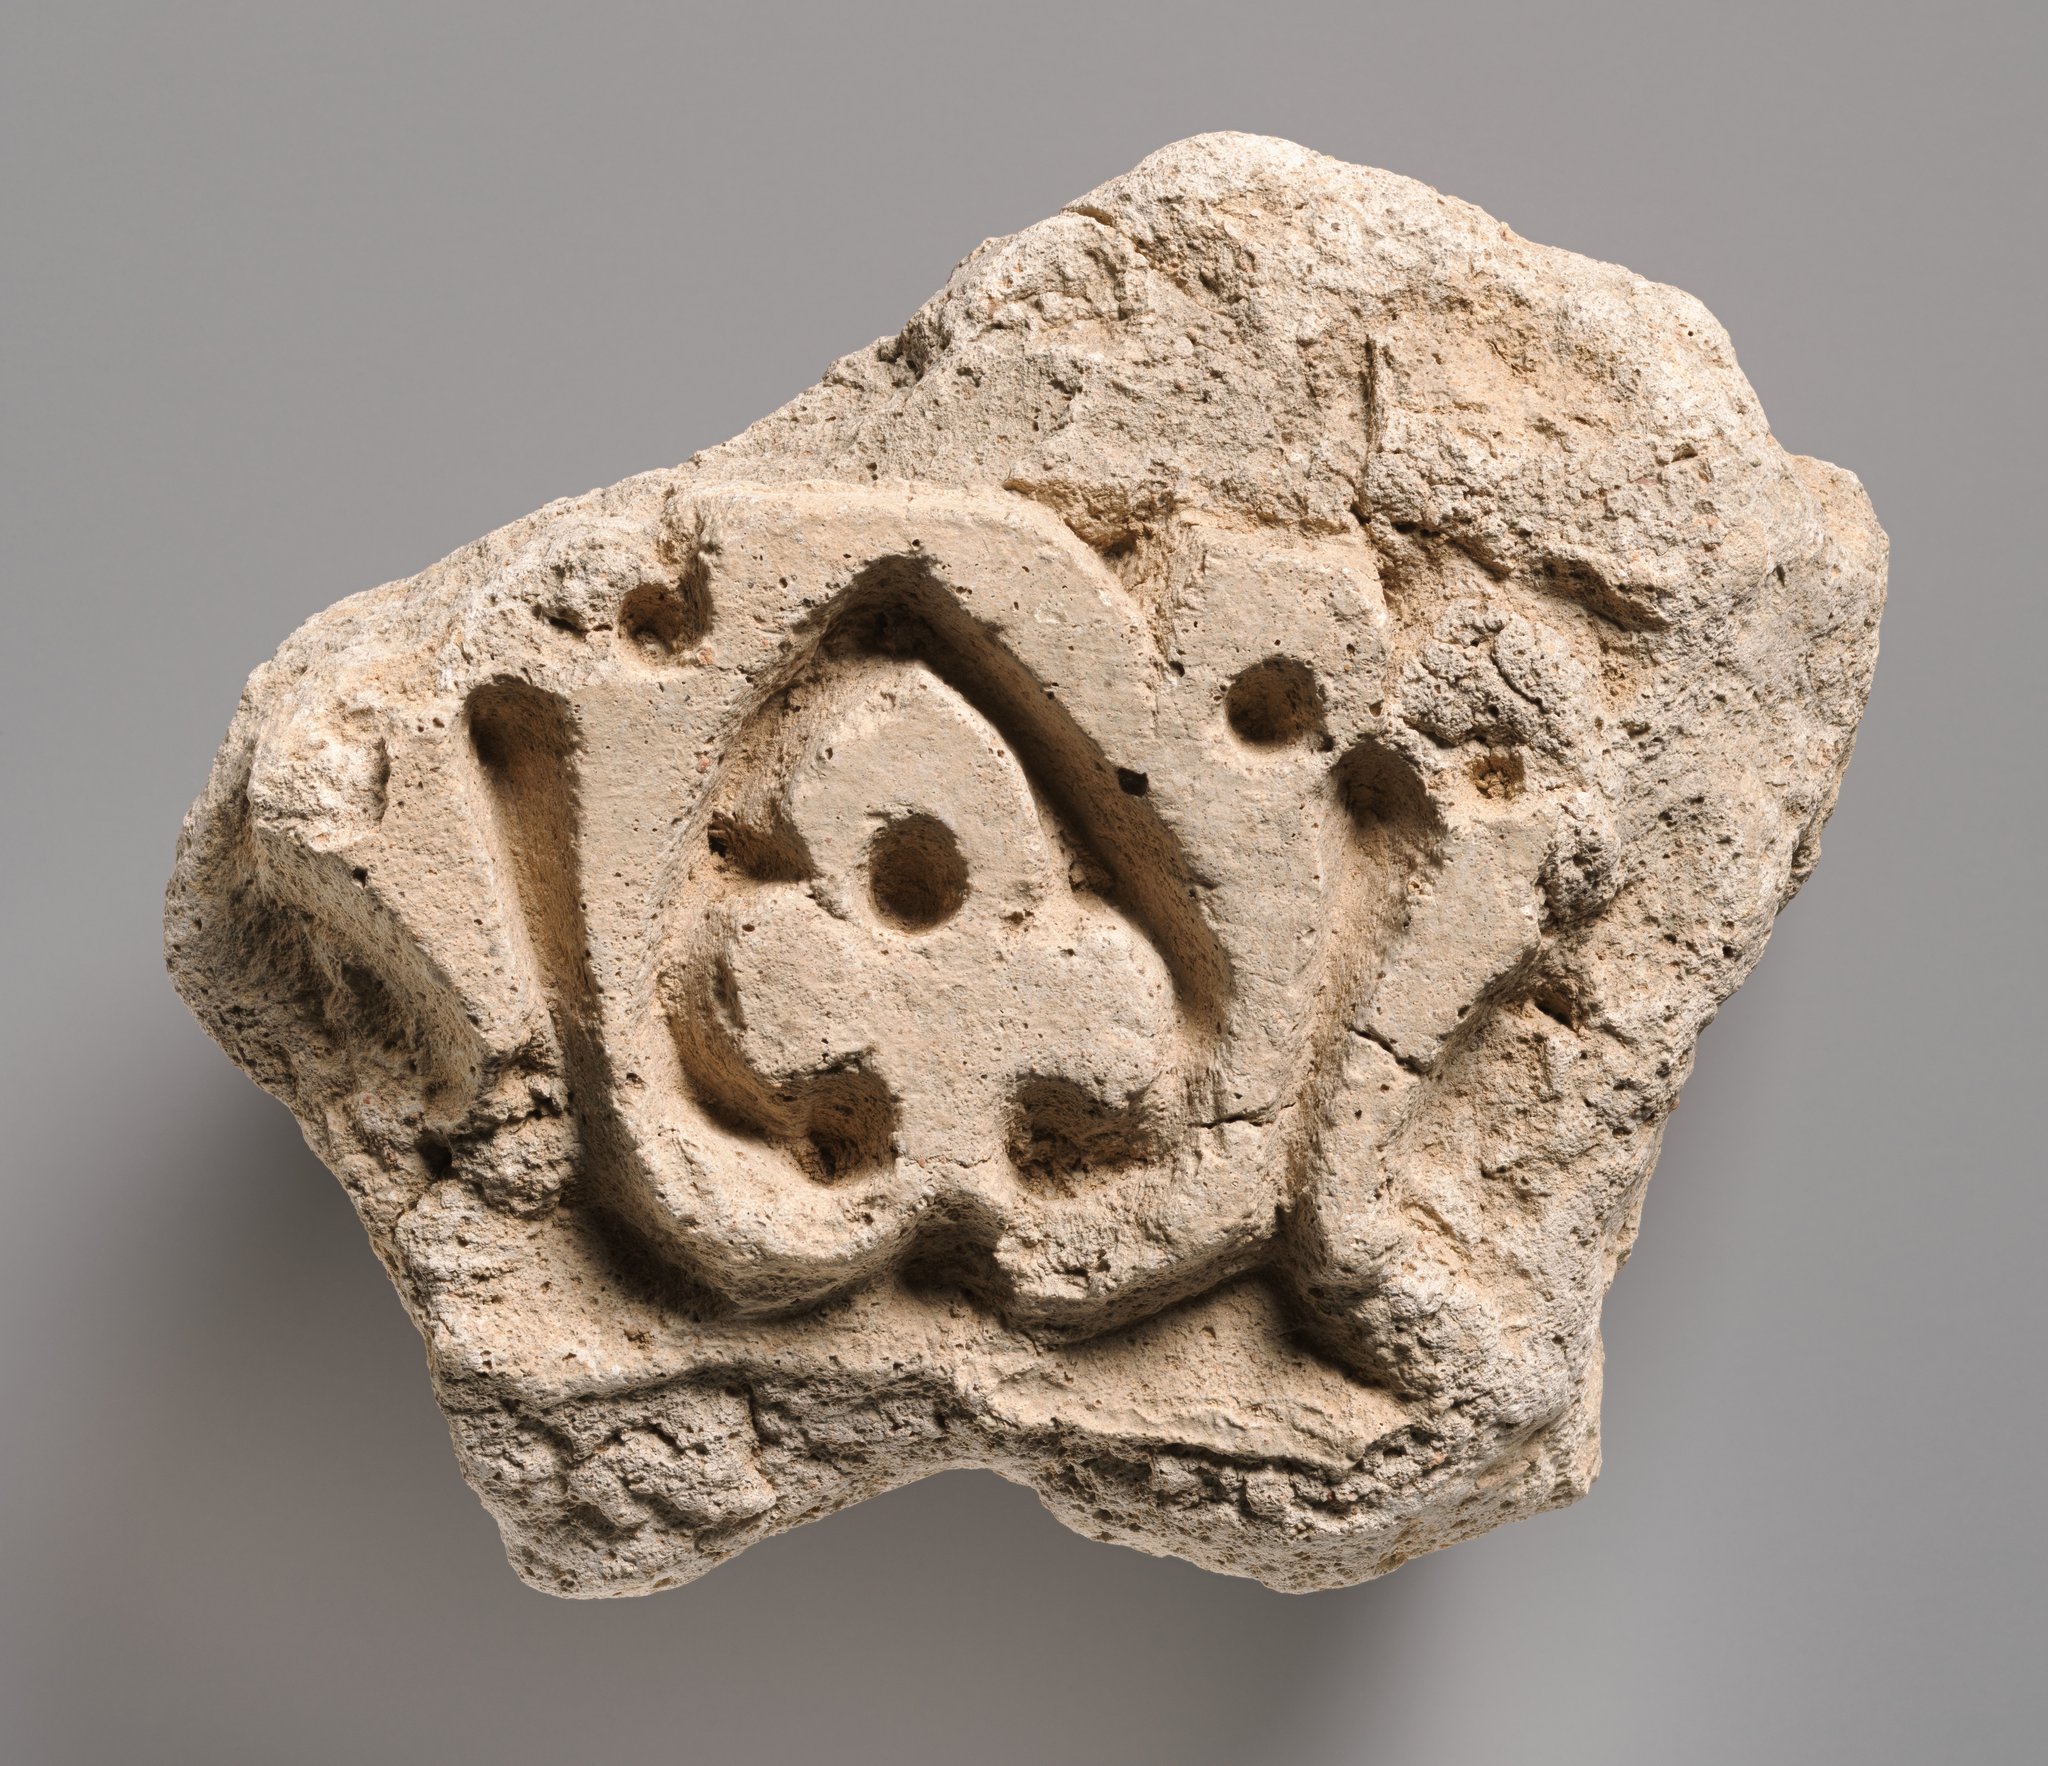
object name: relief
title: Relief fragment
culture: sasanian or islamic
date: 501-800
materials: plaster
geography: mesopotamia